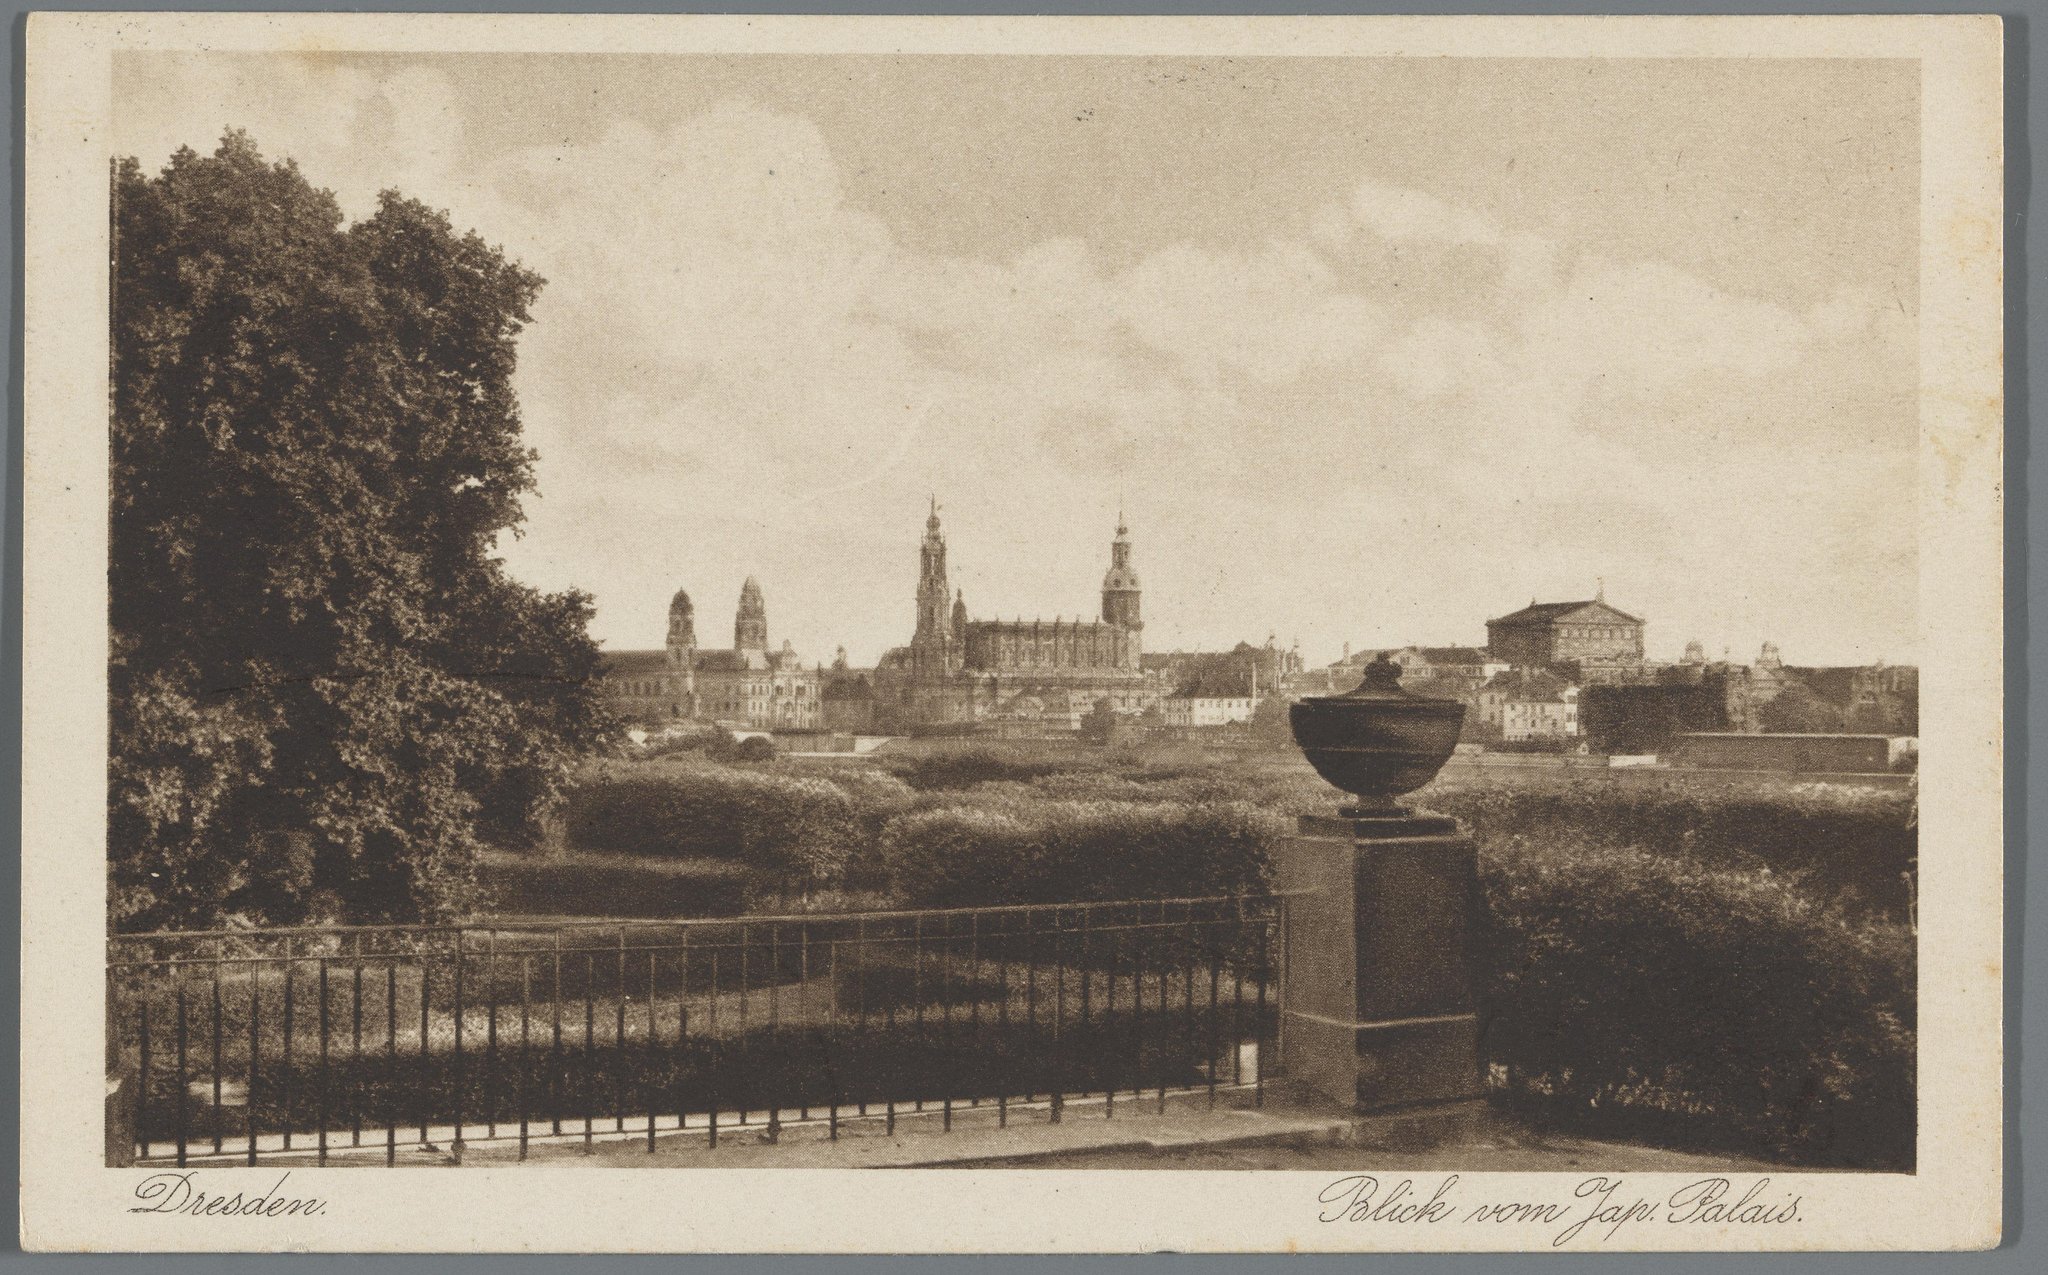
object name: postcard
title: Dresden. Blick vom Japanische Palais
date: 1920-1950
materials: photographic support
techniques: rotogravure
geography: dresden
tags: dresden